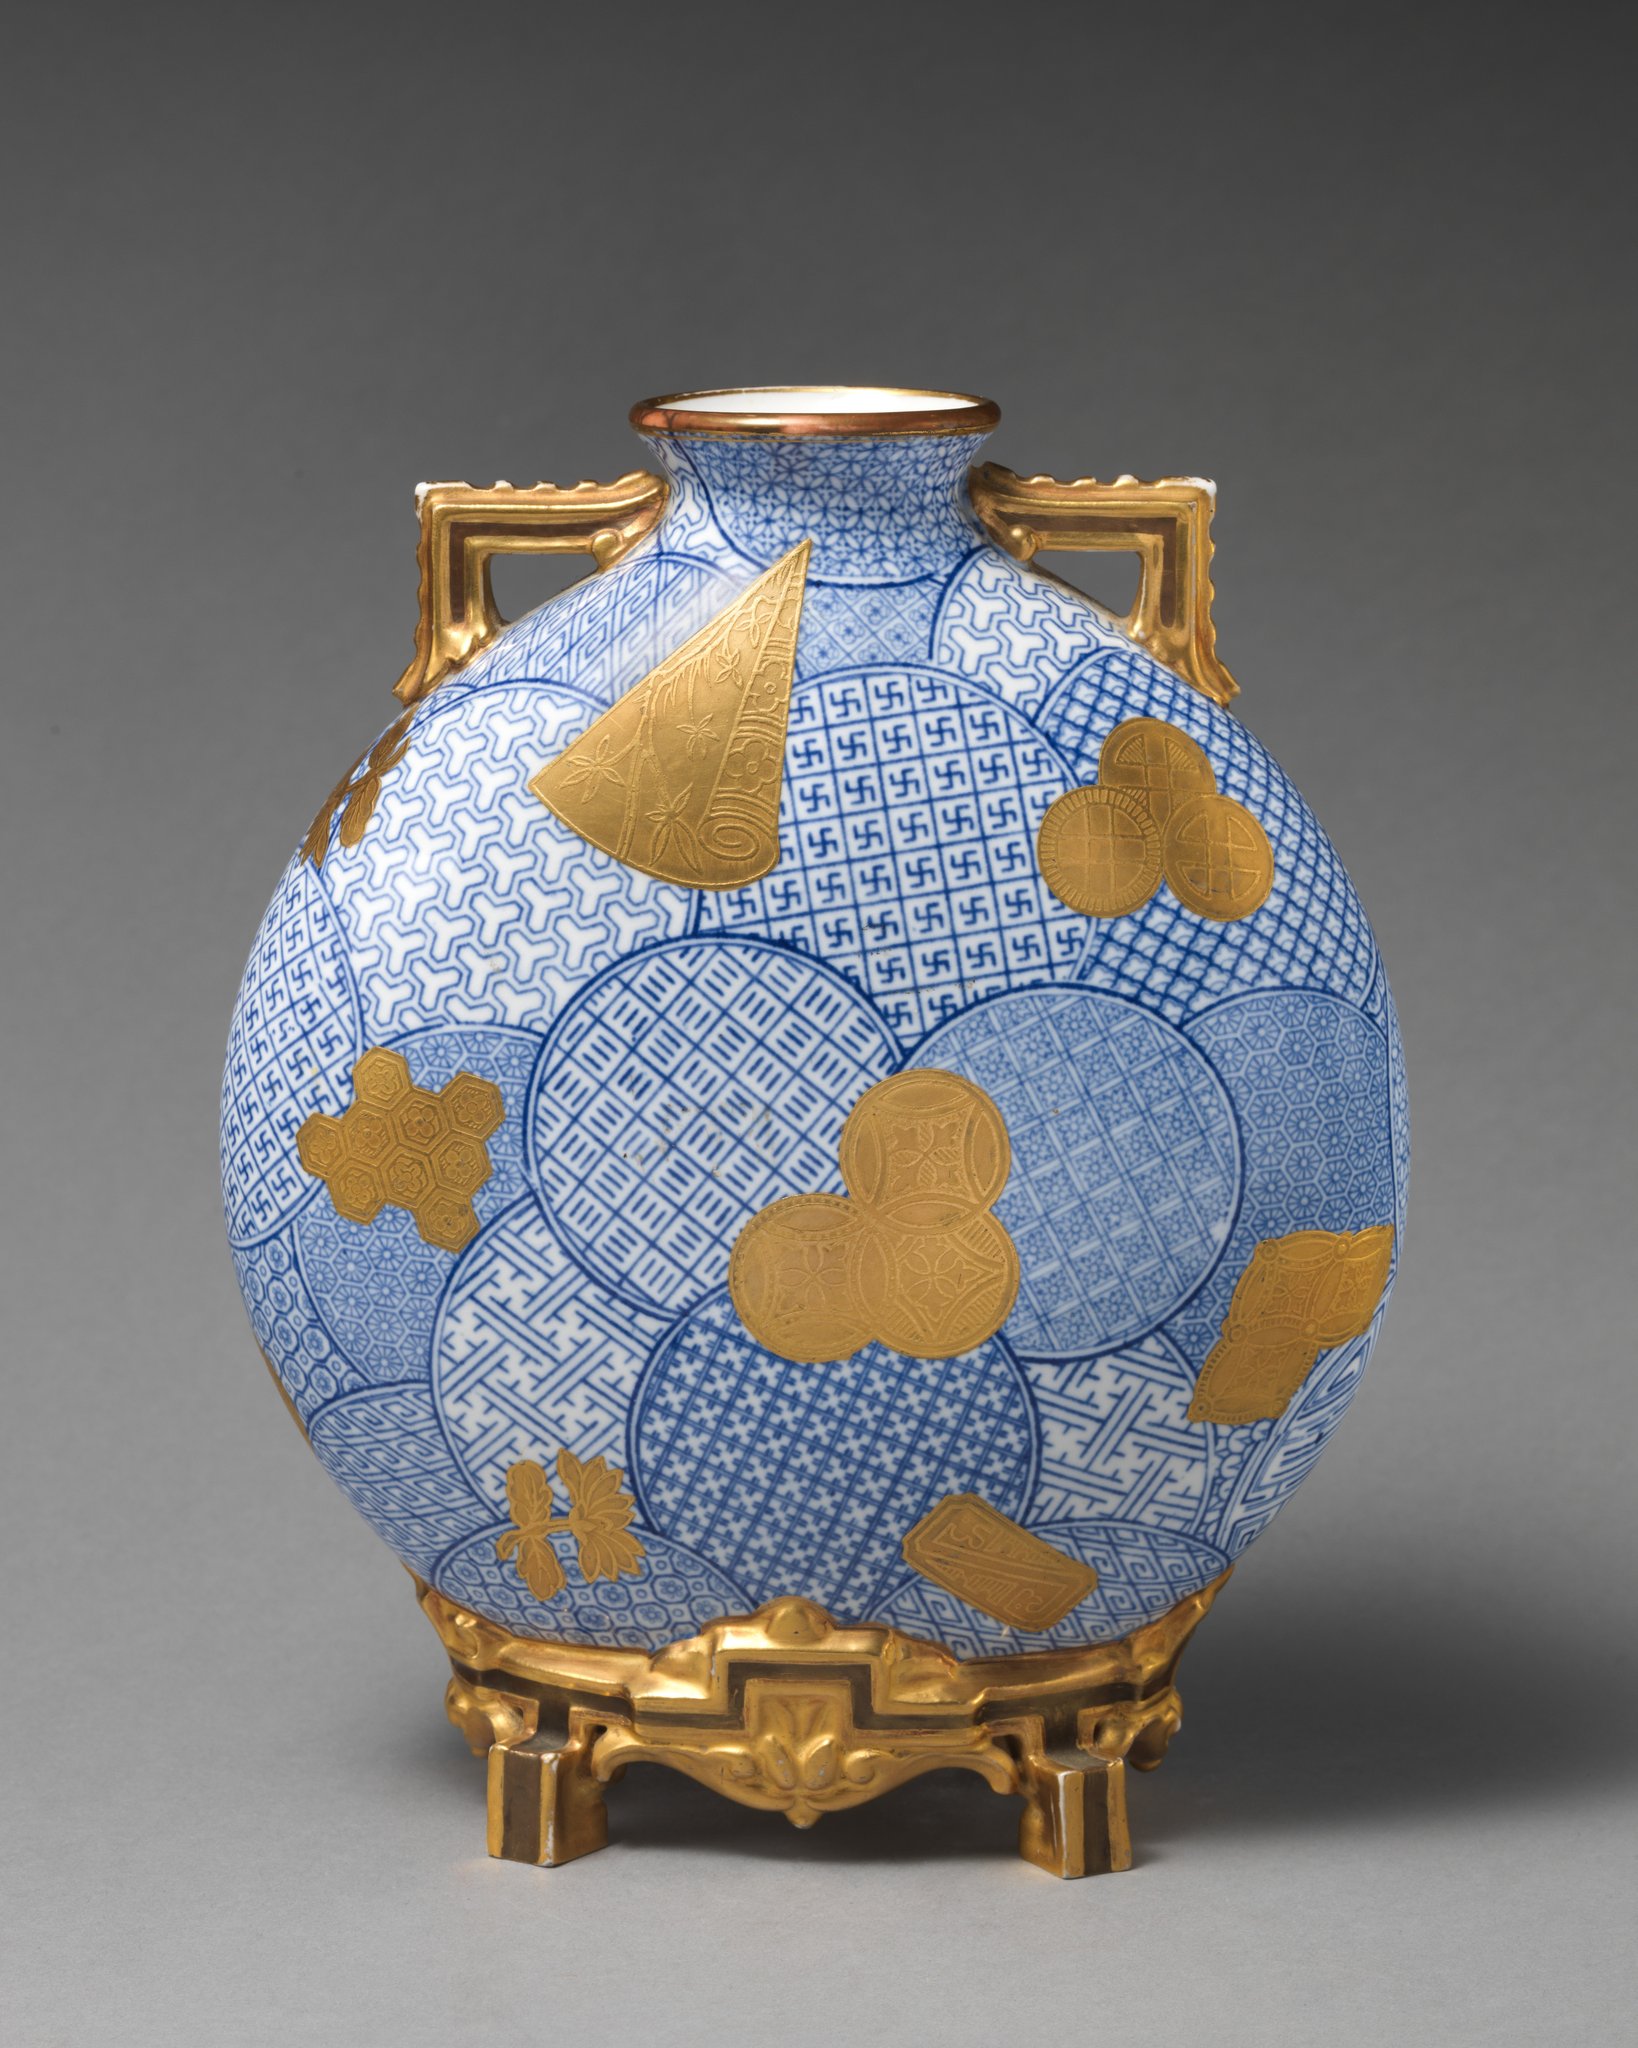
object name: moon flask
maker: worcester factory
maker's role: maker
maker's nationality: british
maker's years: 1751-2008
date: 1878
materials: bone china